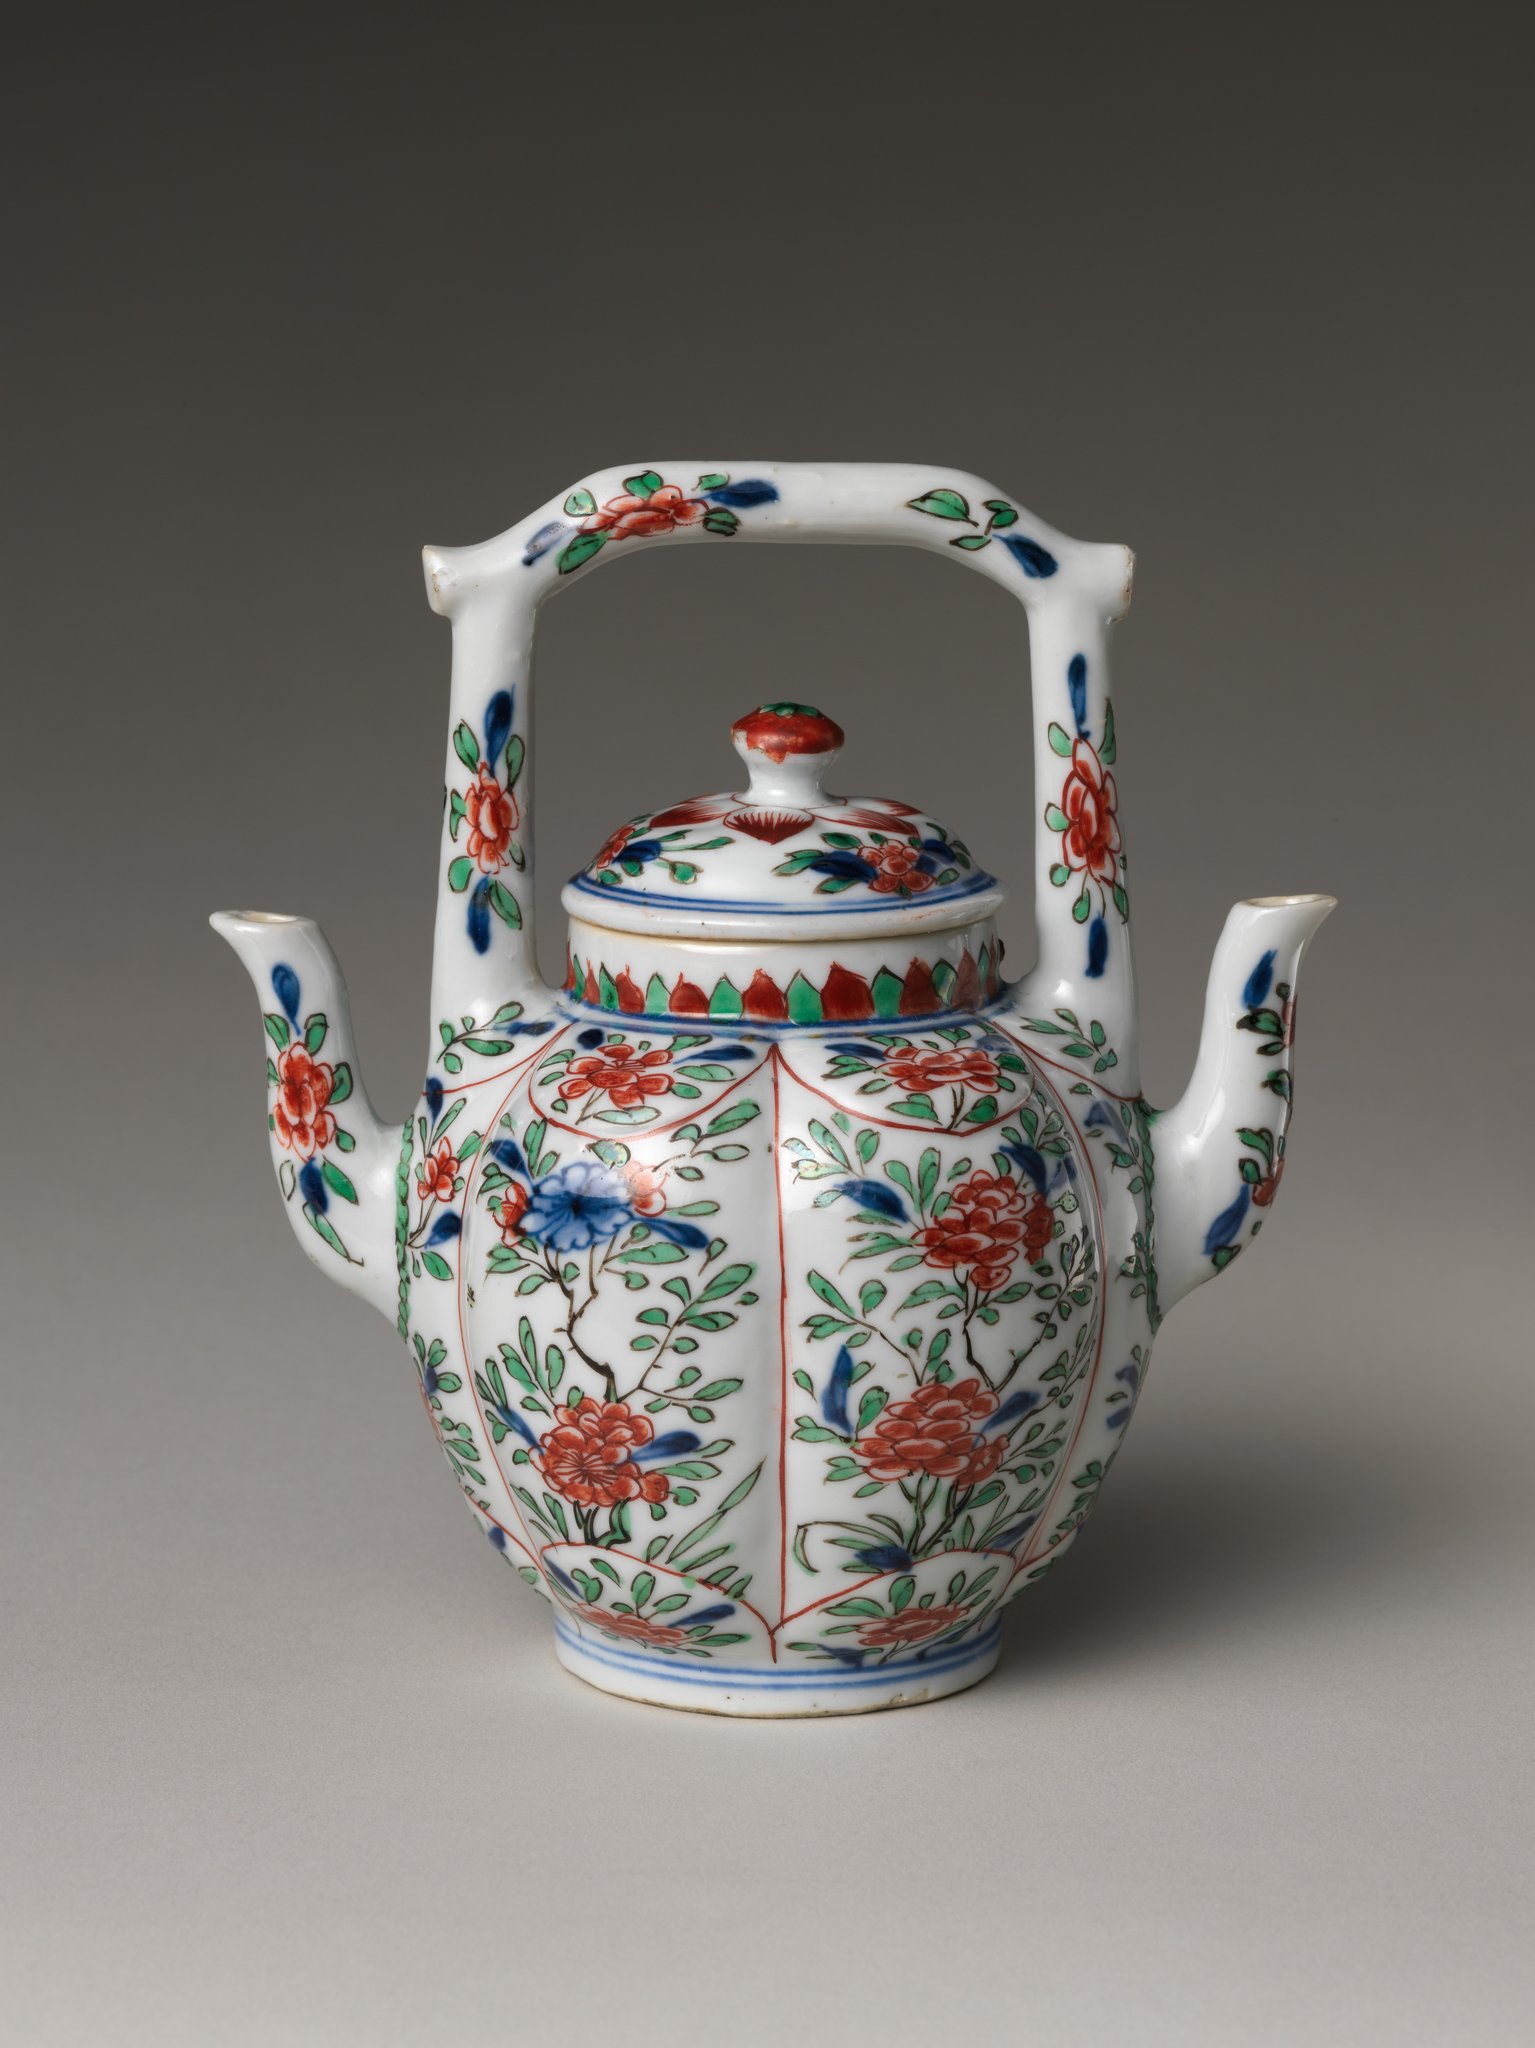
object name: teapot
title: Double-Sided Teapot with Tree Peonies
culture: chinese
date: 1667-1733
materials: cobalt, enamel, glaze, porcelain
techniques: painting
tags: peonies